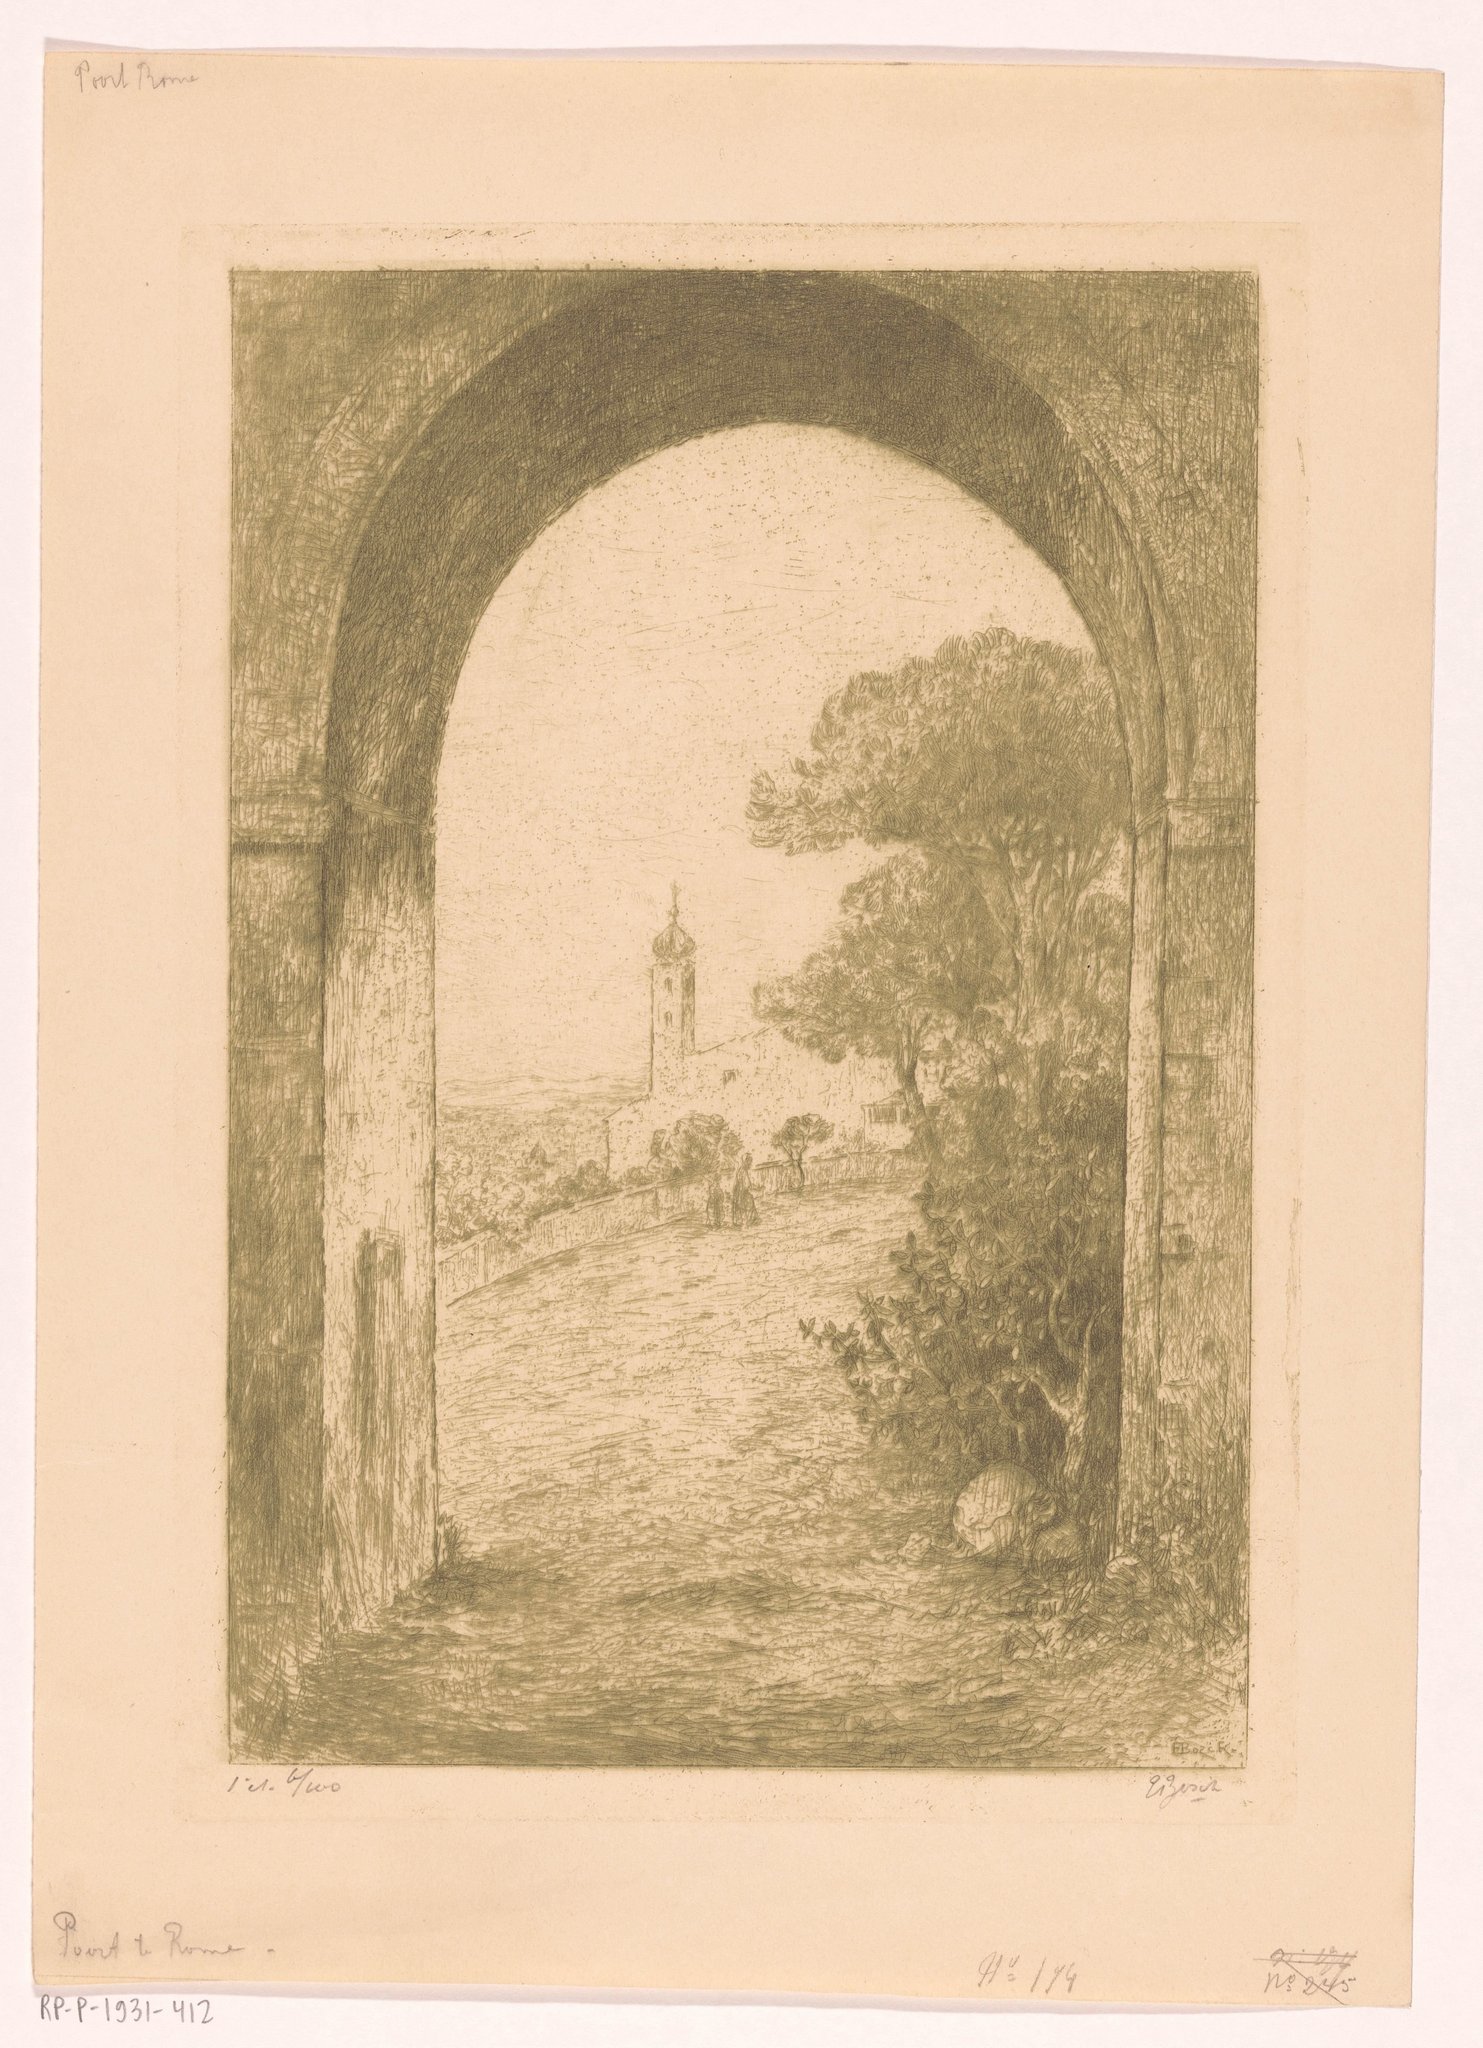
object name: print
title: Poort te Rome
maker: etienne bosch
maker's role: print maker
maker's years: 1863-1933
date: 1873-1931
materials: paper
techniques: etching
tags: low hill country, city-gate, tower (of house or building), rome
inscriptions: number: ‘no. 174’, collector's mark: Lugt 2228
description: Zicht door een poort op een heuvellandschap met daarin een gebouw met toren.